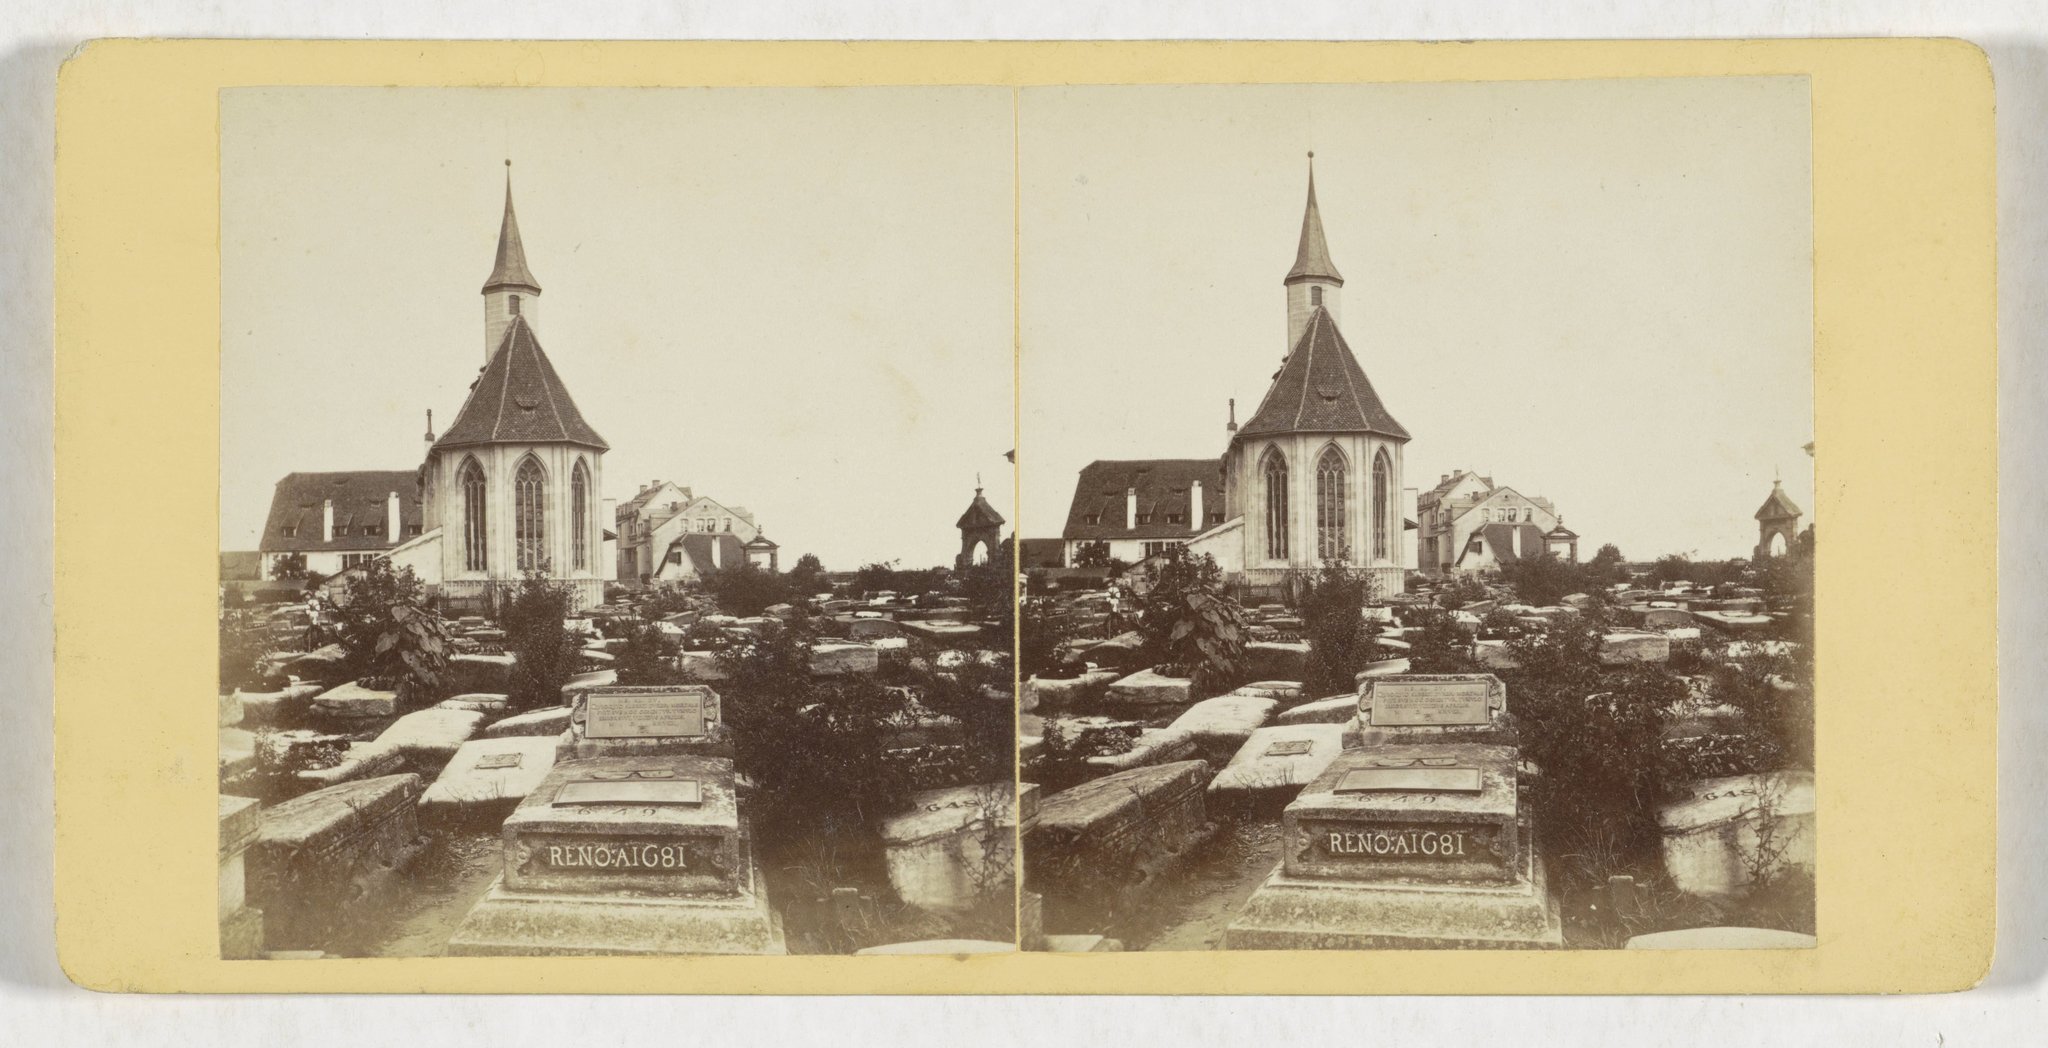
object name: stereograph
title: Deutschland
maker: johann friedrich stiehm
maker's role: fotograaf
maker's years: 1826-1902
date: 1868-1888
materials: cardboard, paper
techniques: albumen print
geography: nuremberg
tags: painter, print maker, draughtsman, albrecht dürer, grave, tomb, churchyard (around church)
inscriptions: number: ‘No. 28.’